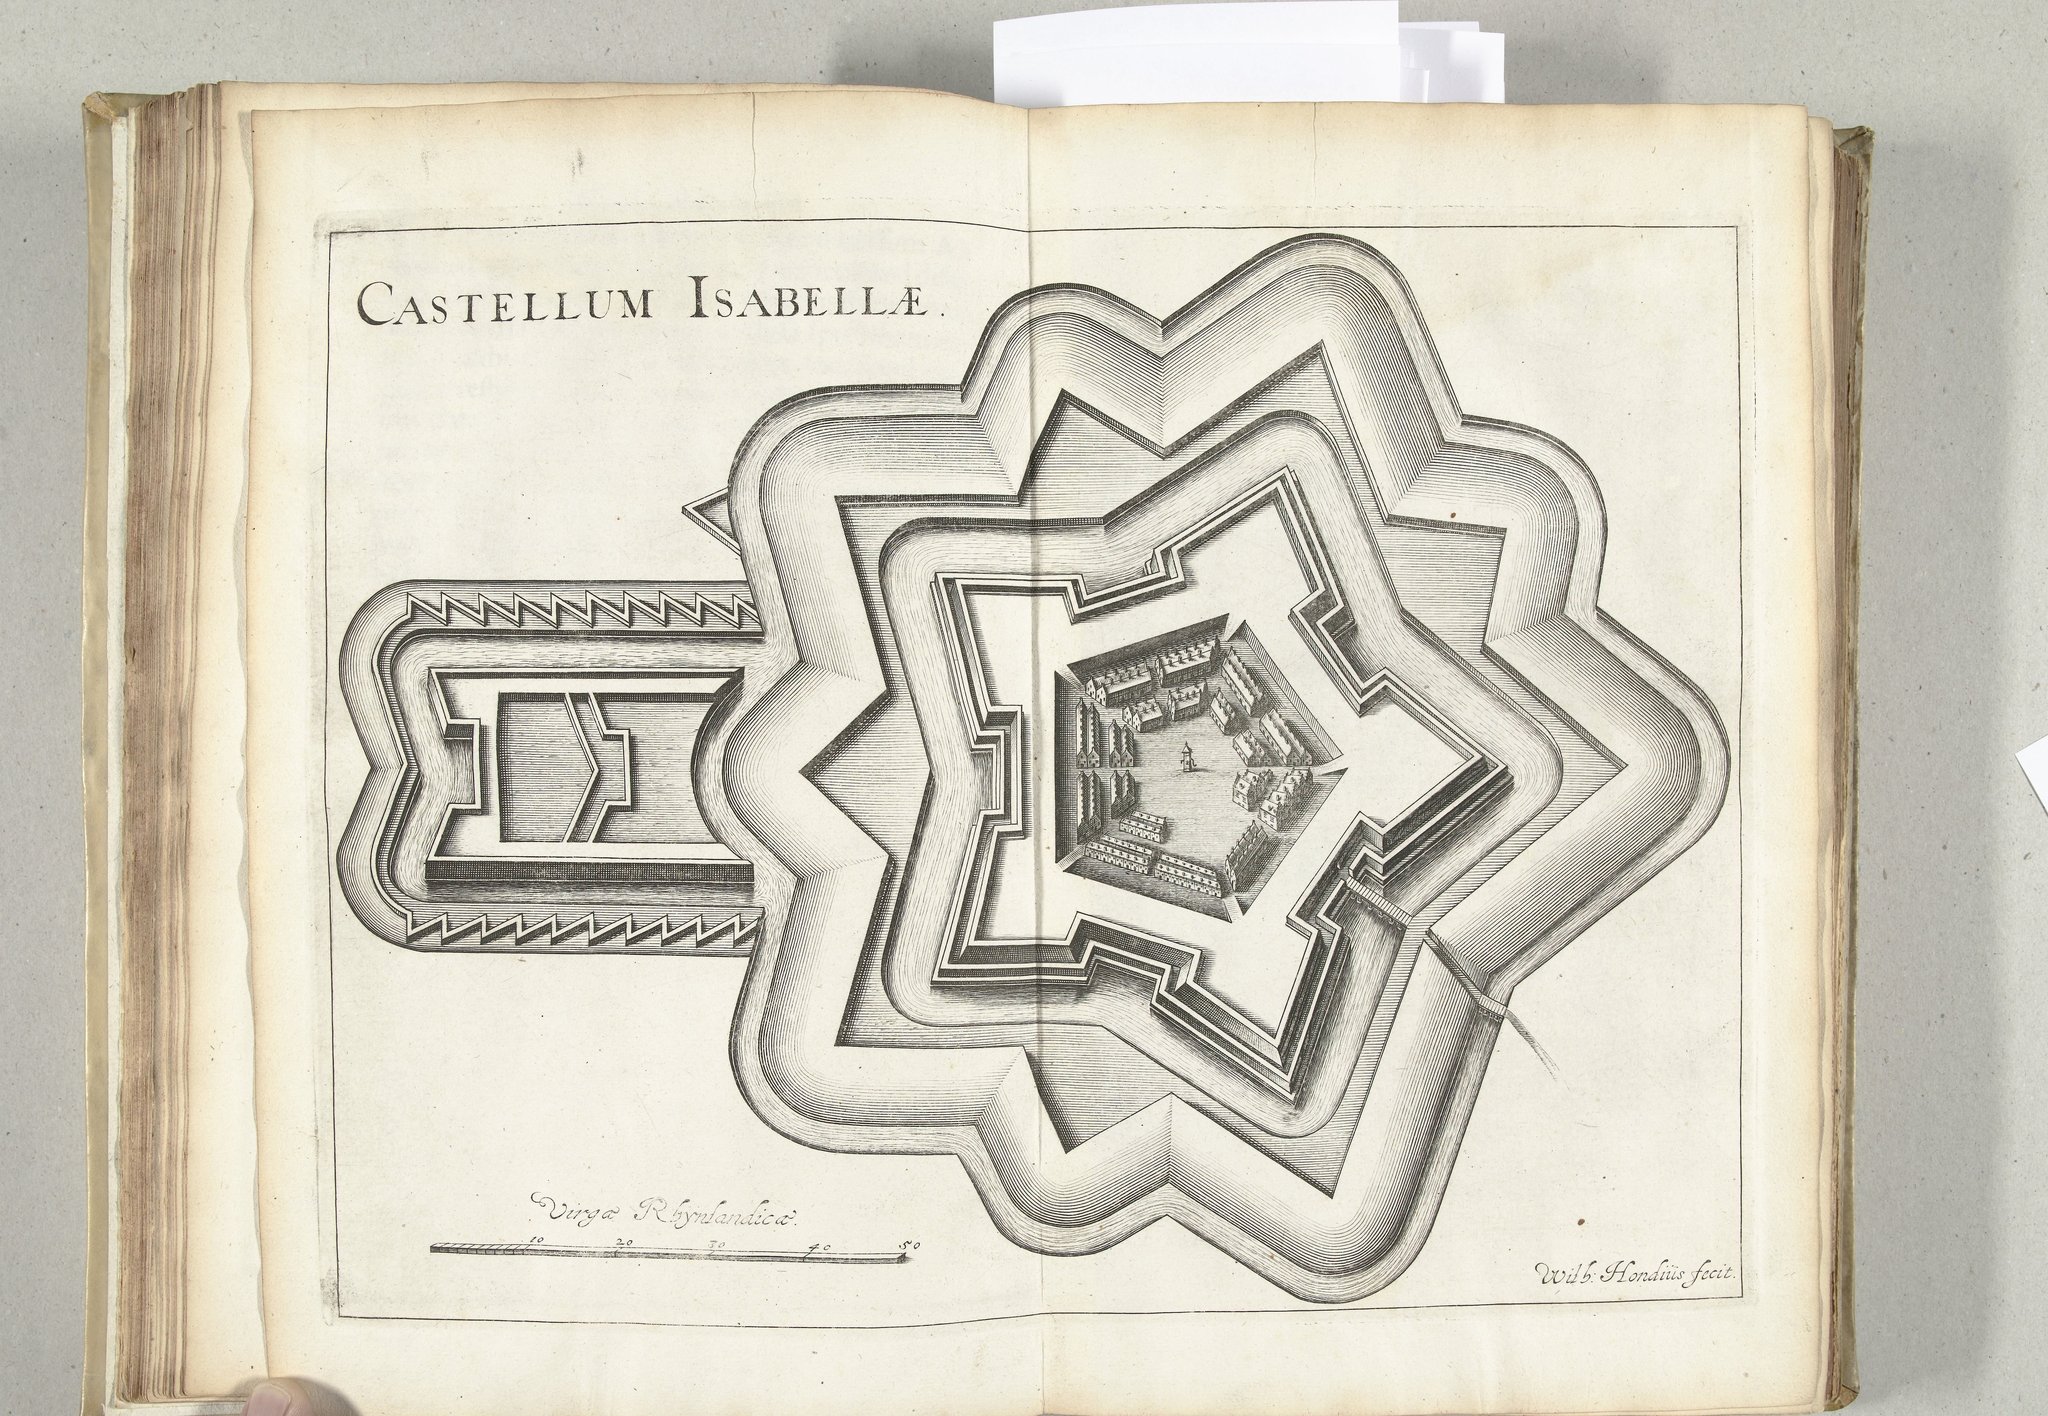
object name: area plan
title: Fort Isabella, 1629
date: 1631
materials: paper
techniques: engraving, etching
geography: leiden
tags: delft, the hague, frederick henry (prince of orange), fortifications, military engineering, den bosch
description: Prent ook gebruikt in: Heinsius, Daniel. Rerum ad Sylvam-Ducis atque alibi in Belgio aut a Belgio anno 1629 gestarum historia. Leiden: Ex Officina Elzeviriorum, 1631, p. 38-39. In het exemplaar in de Rijksmuseum Research Library, signatuur 327 I 25.